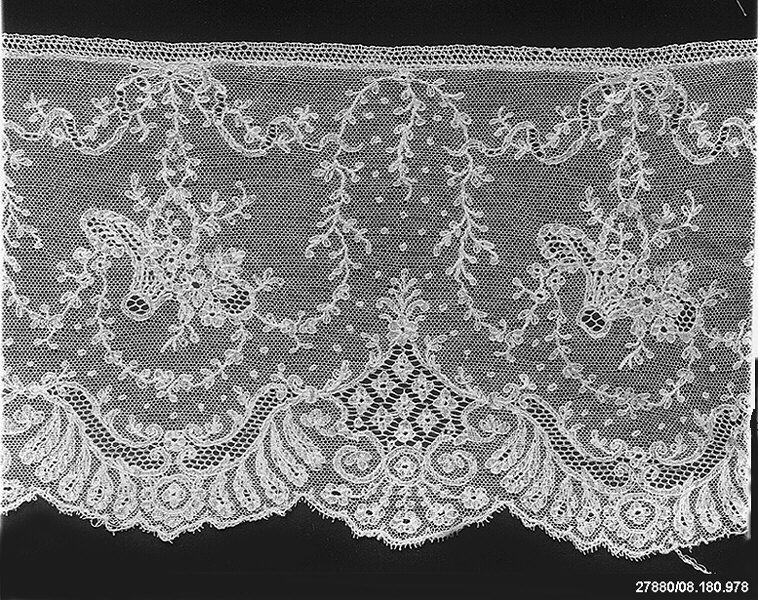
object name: fragment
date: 1801-1900